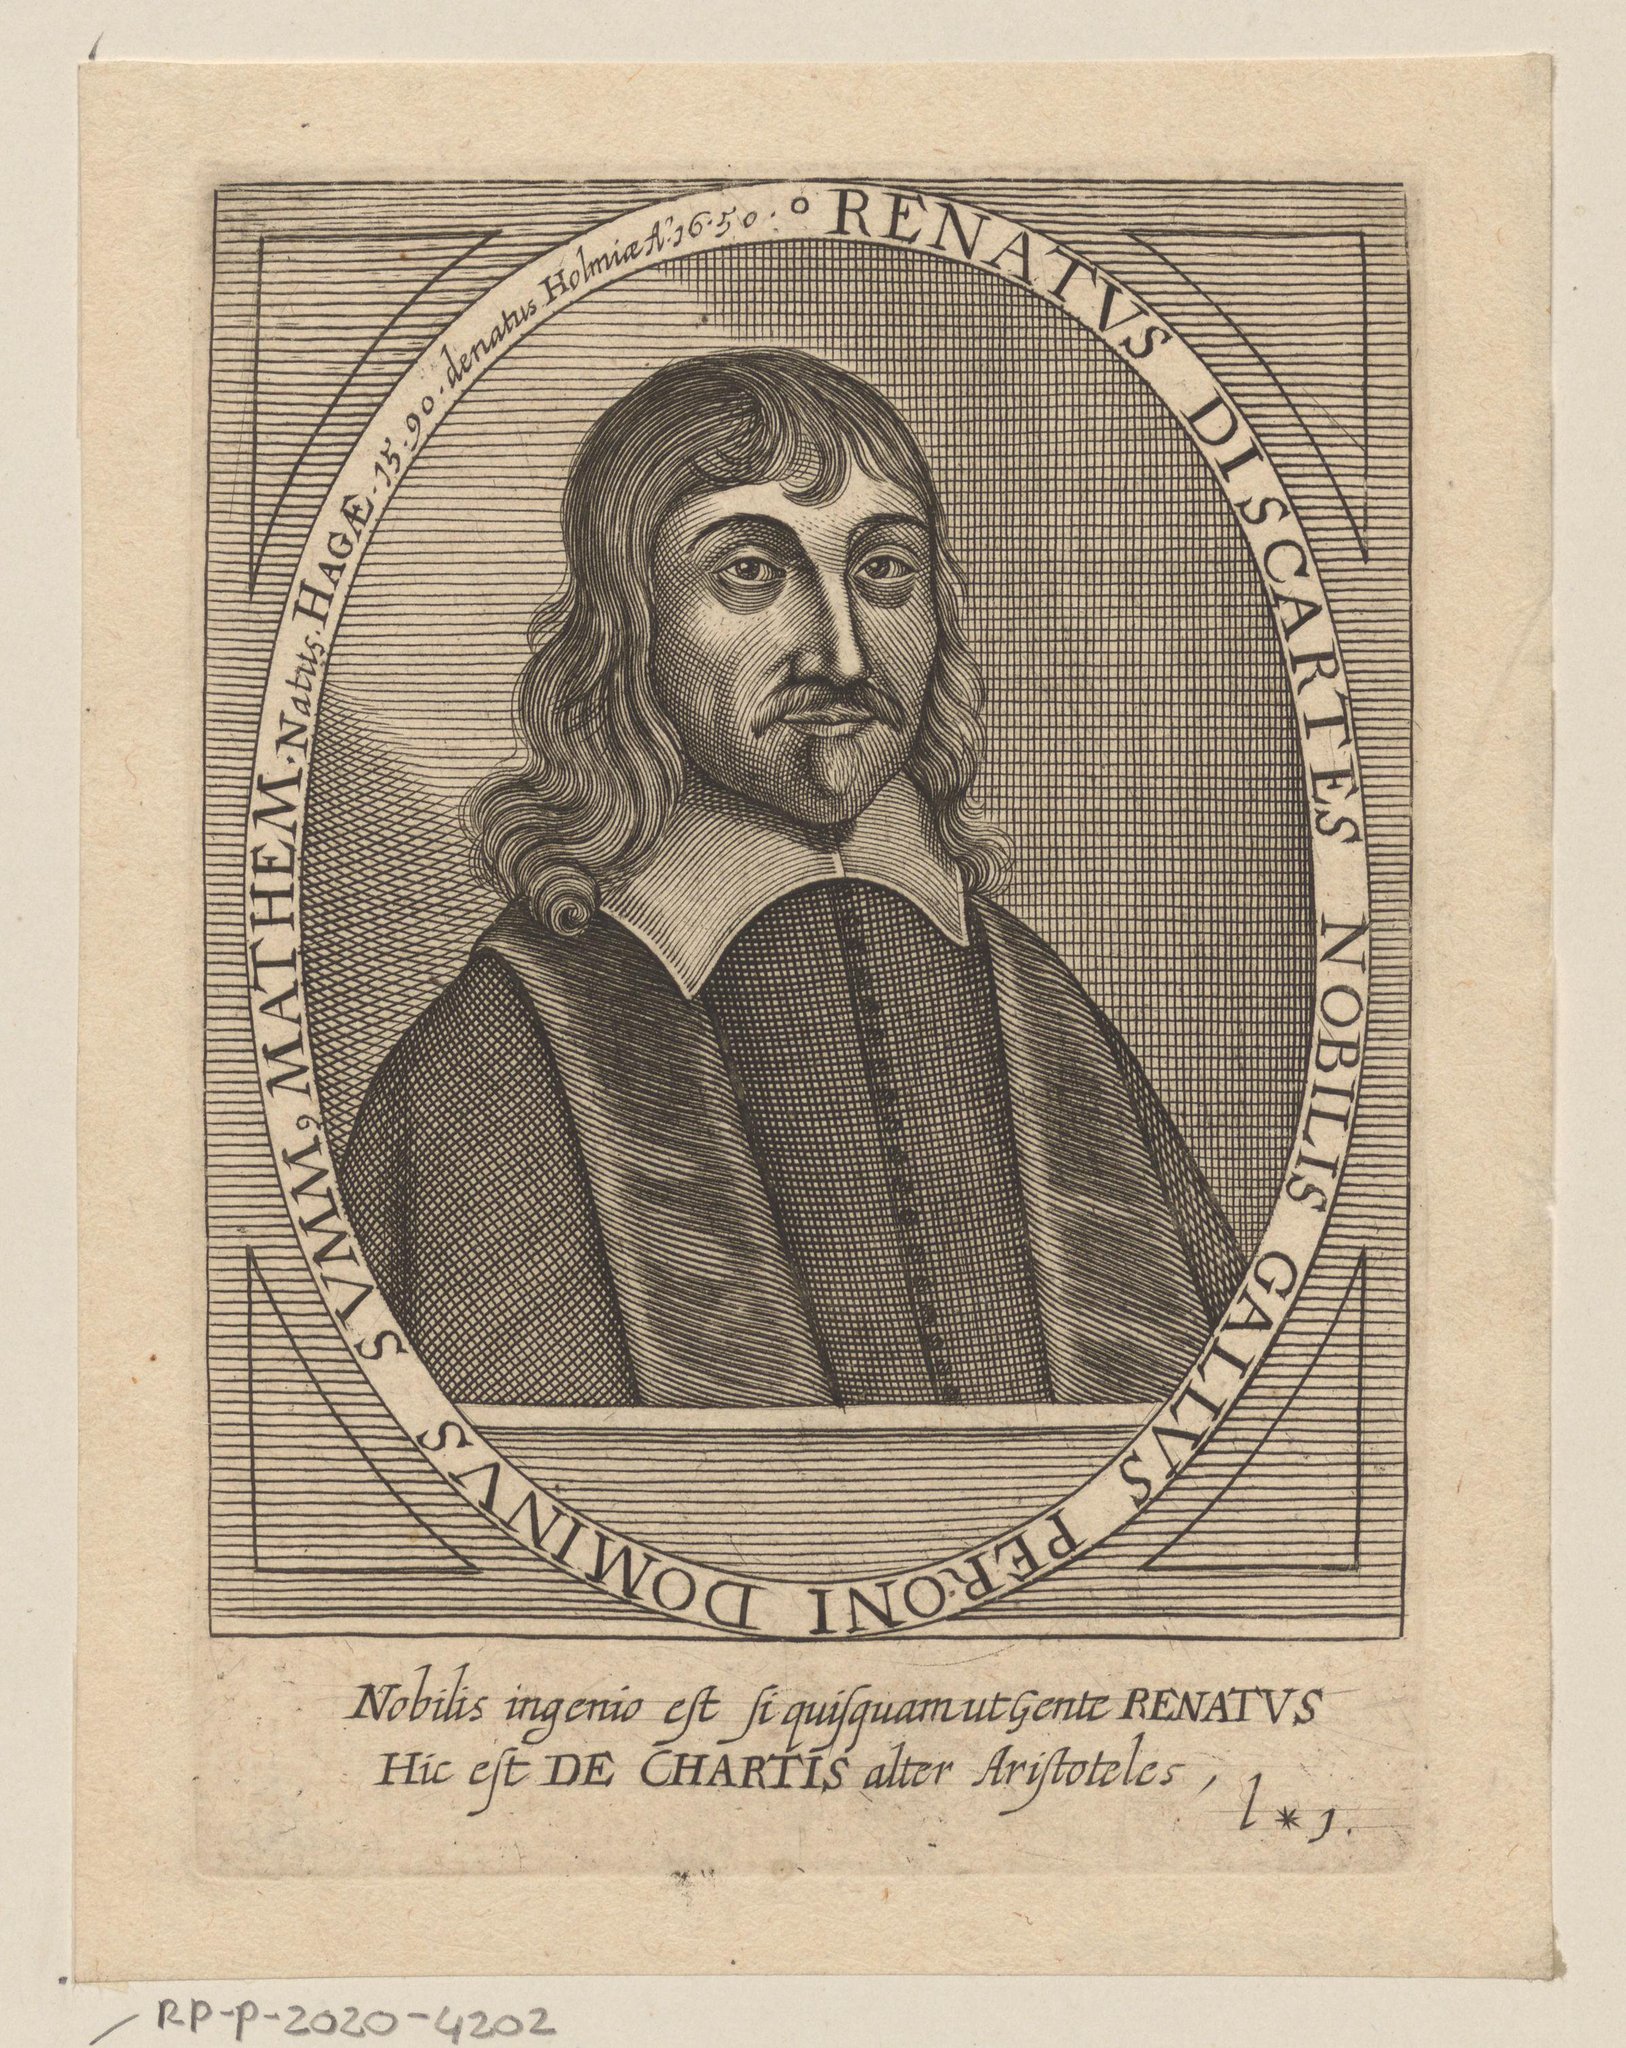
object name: print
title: Portret van René Descartes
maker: Anonymous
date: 1654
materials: paper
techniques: engraving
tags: rené descartes, scholar, philosopher, historical persons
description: Prent mogelijk uit: Bibliotheca chalcographica. IX pars. Heidelberg: Johannes Ammon, 1654.